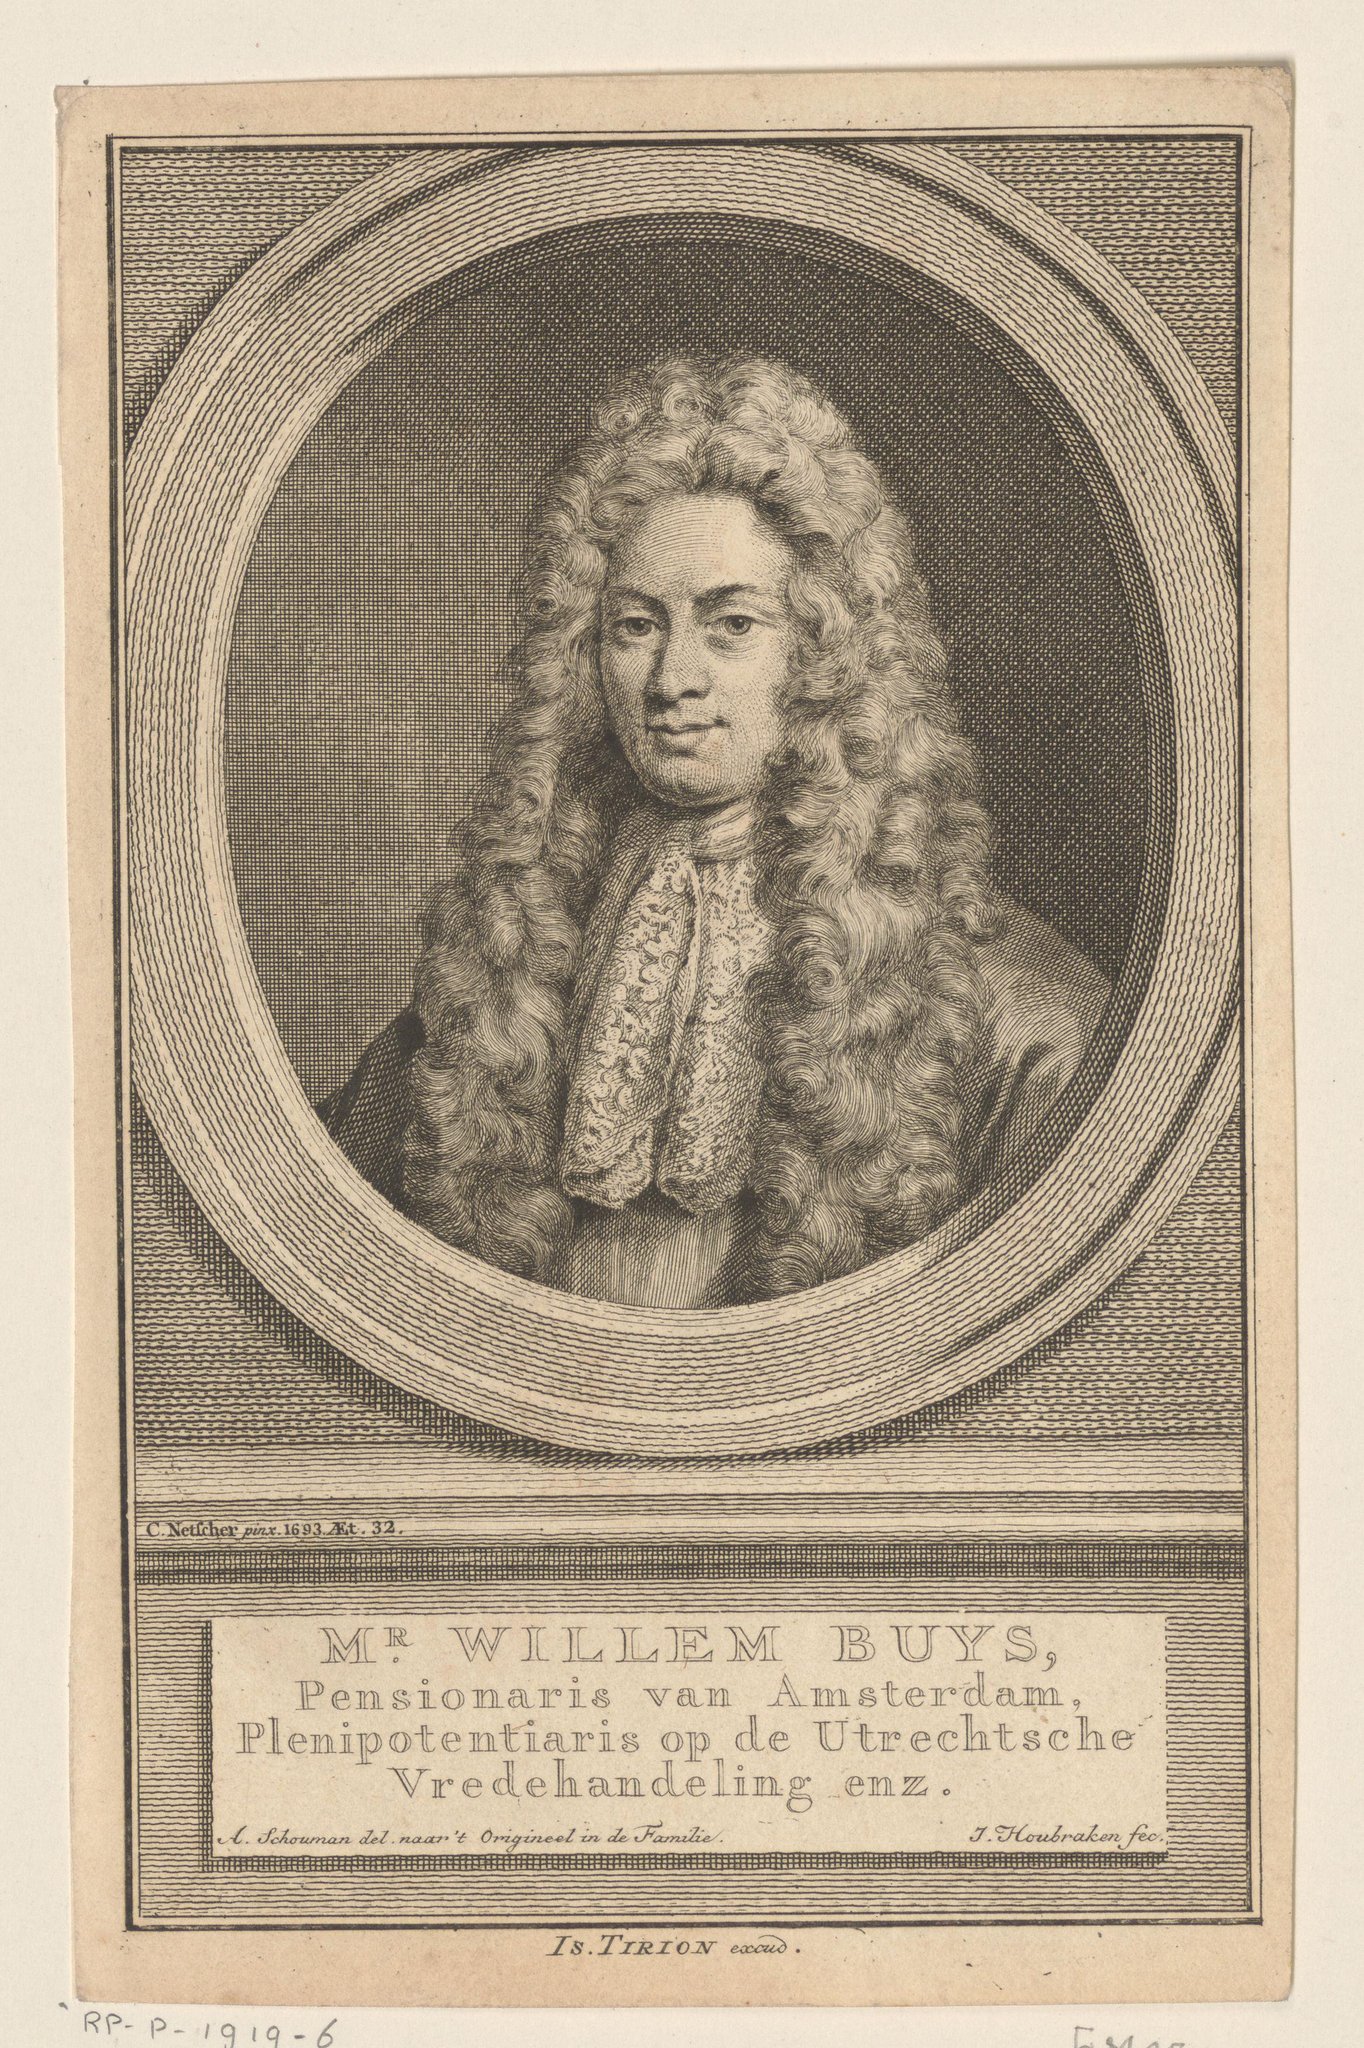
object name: book illustration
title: Portret van Willem Buys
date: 1749-1759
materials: paper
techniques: engraving, etching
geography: amsterdam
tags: historical persons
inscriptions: collector's mark: Lugt 2228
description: Prent voor het eerst verschenen in: Wagenaar, Jan. Vaderlandsche historie, vervattende de geschiedenissen der nu Vereenigde Nederlanden, inzonderheid die van Holland (...). 21 dln. Amsterdam: Isaak Tirion, 1749-1759, dl. 7. Prent ook gebruikt in latere edities van dit werk.